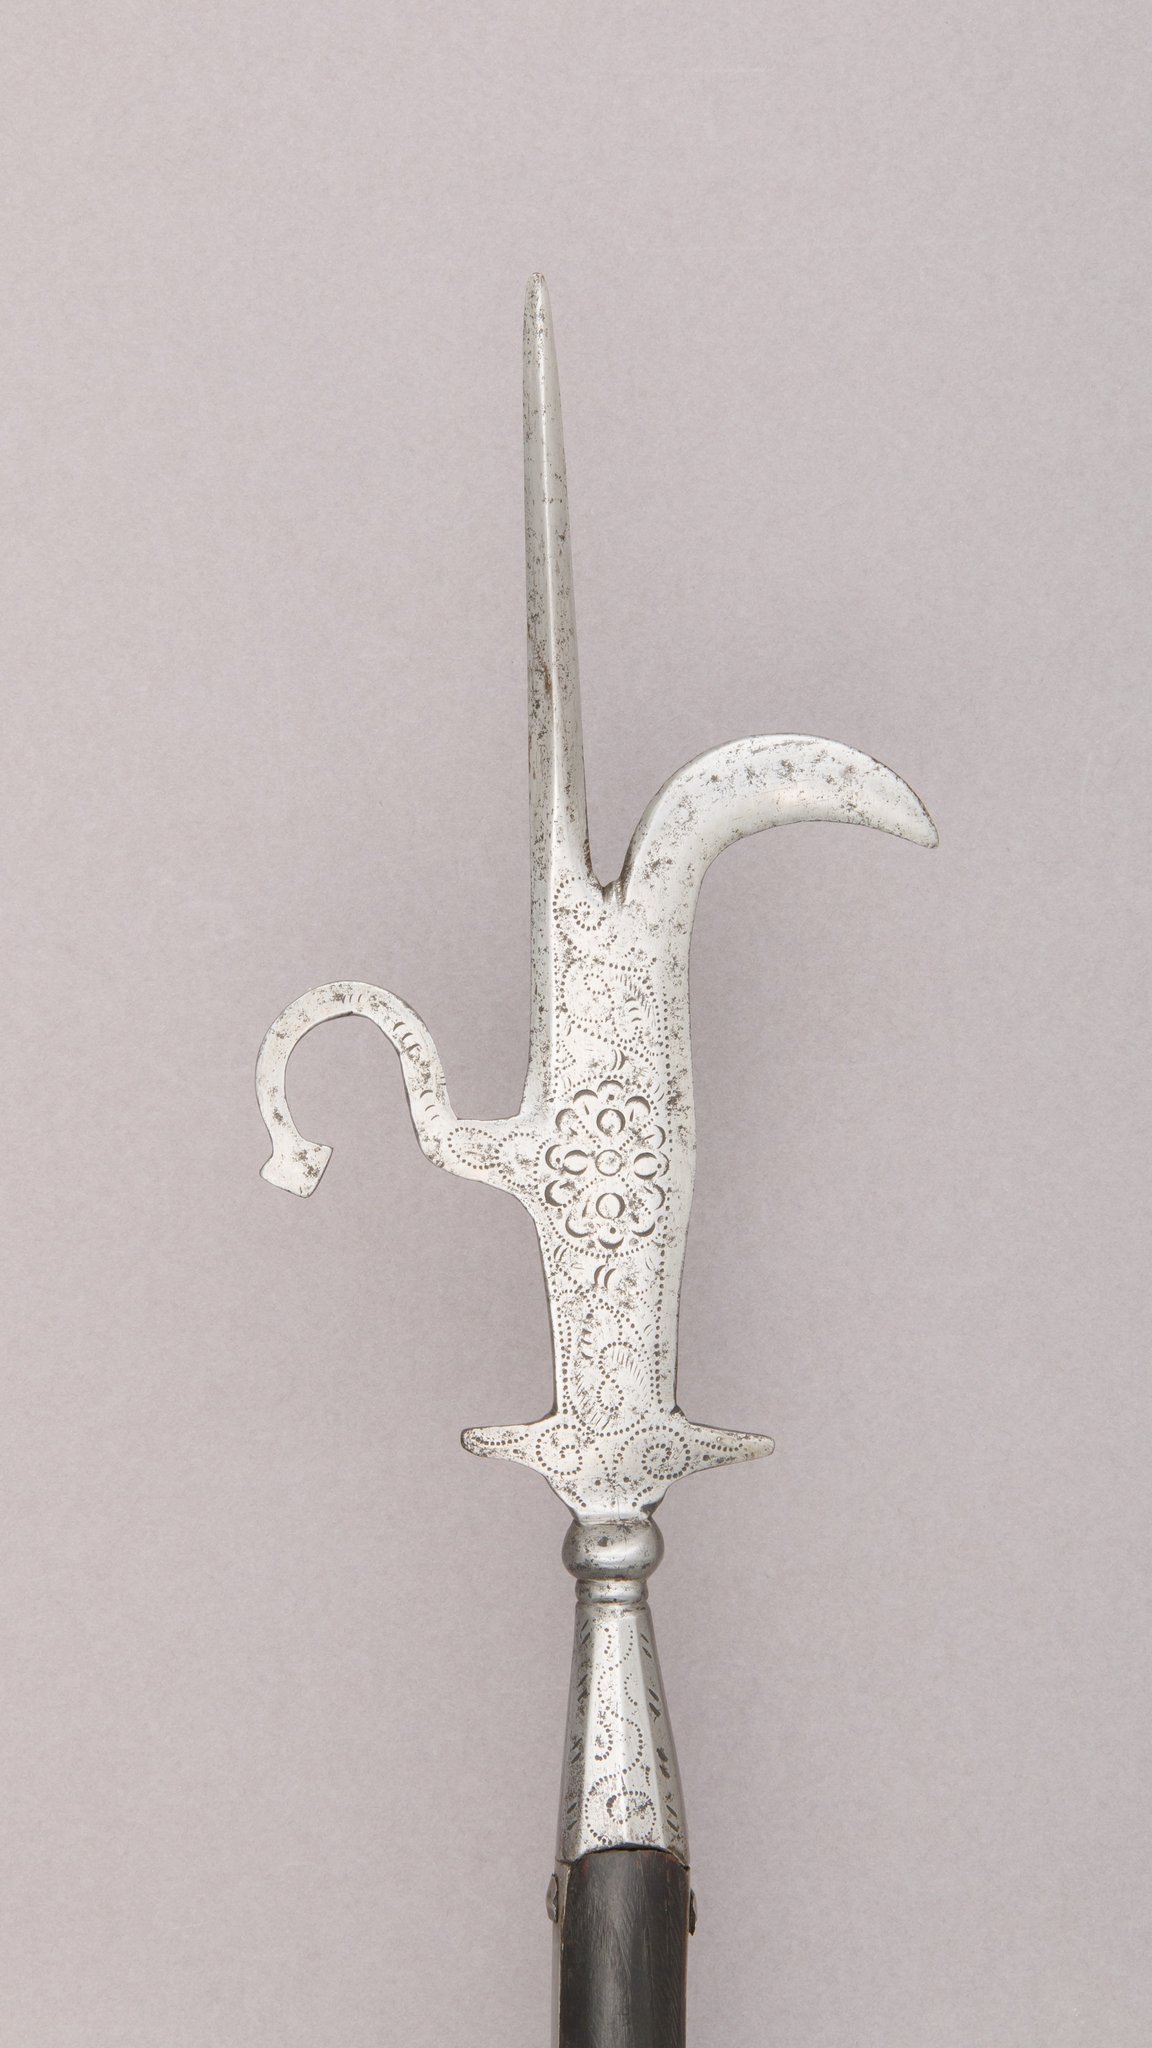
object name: guisarme for a child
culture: italian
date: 1601-1700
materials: steel, wood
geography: italy